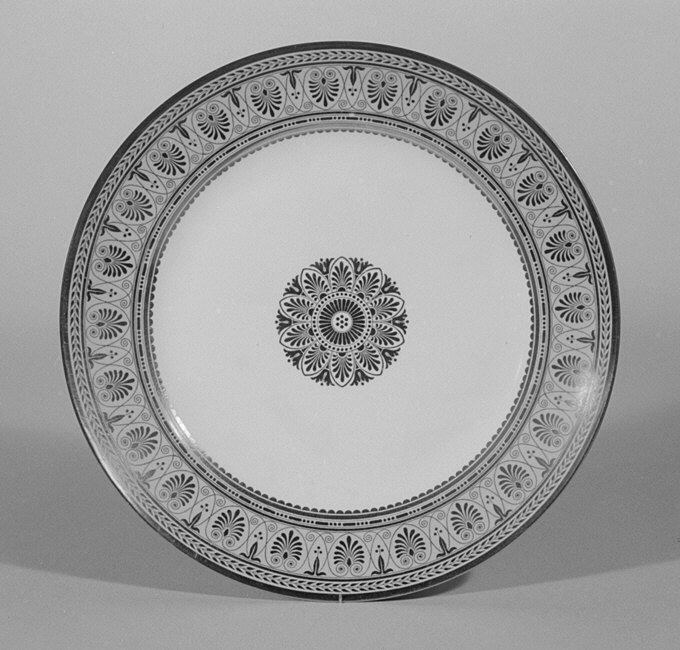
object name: soup plate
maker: sèvres manufactory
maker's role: manufactory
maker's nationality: french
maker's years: 1740-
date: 1838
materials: hard paste porcelain